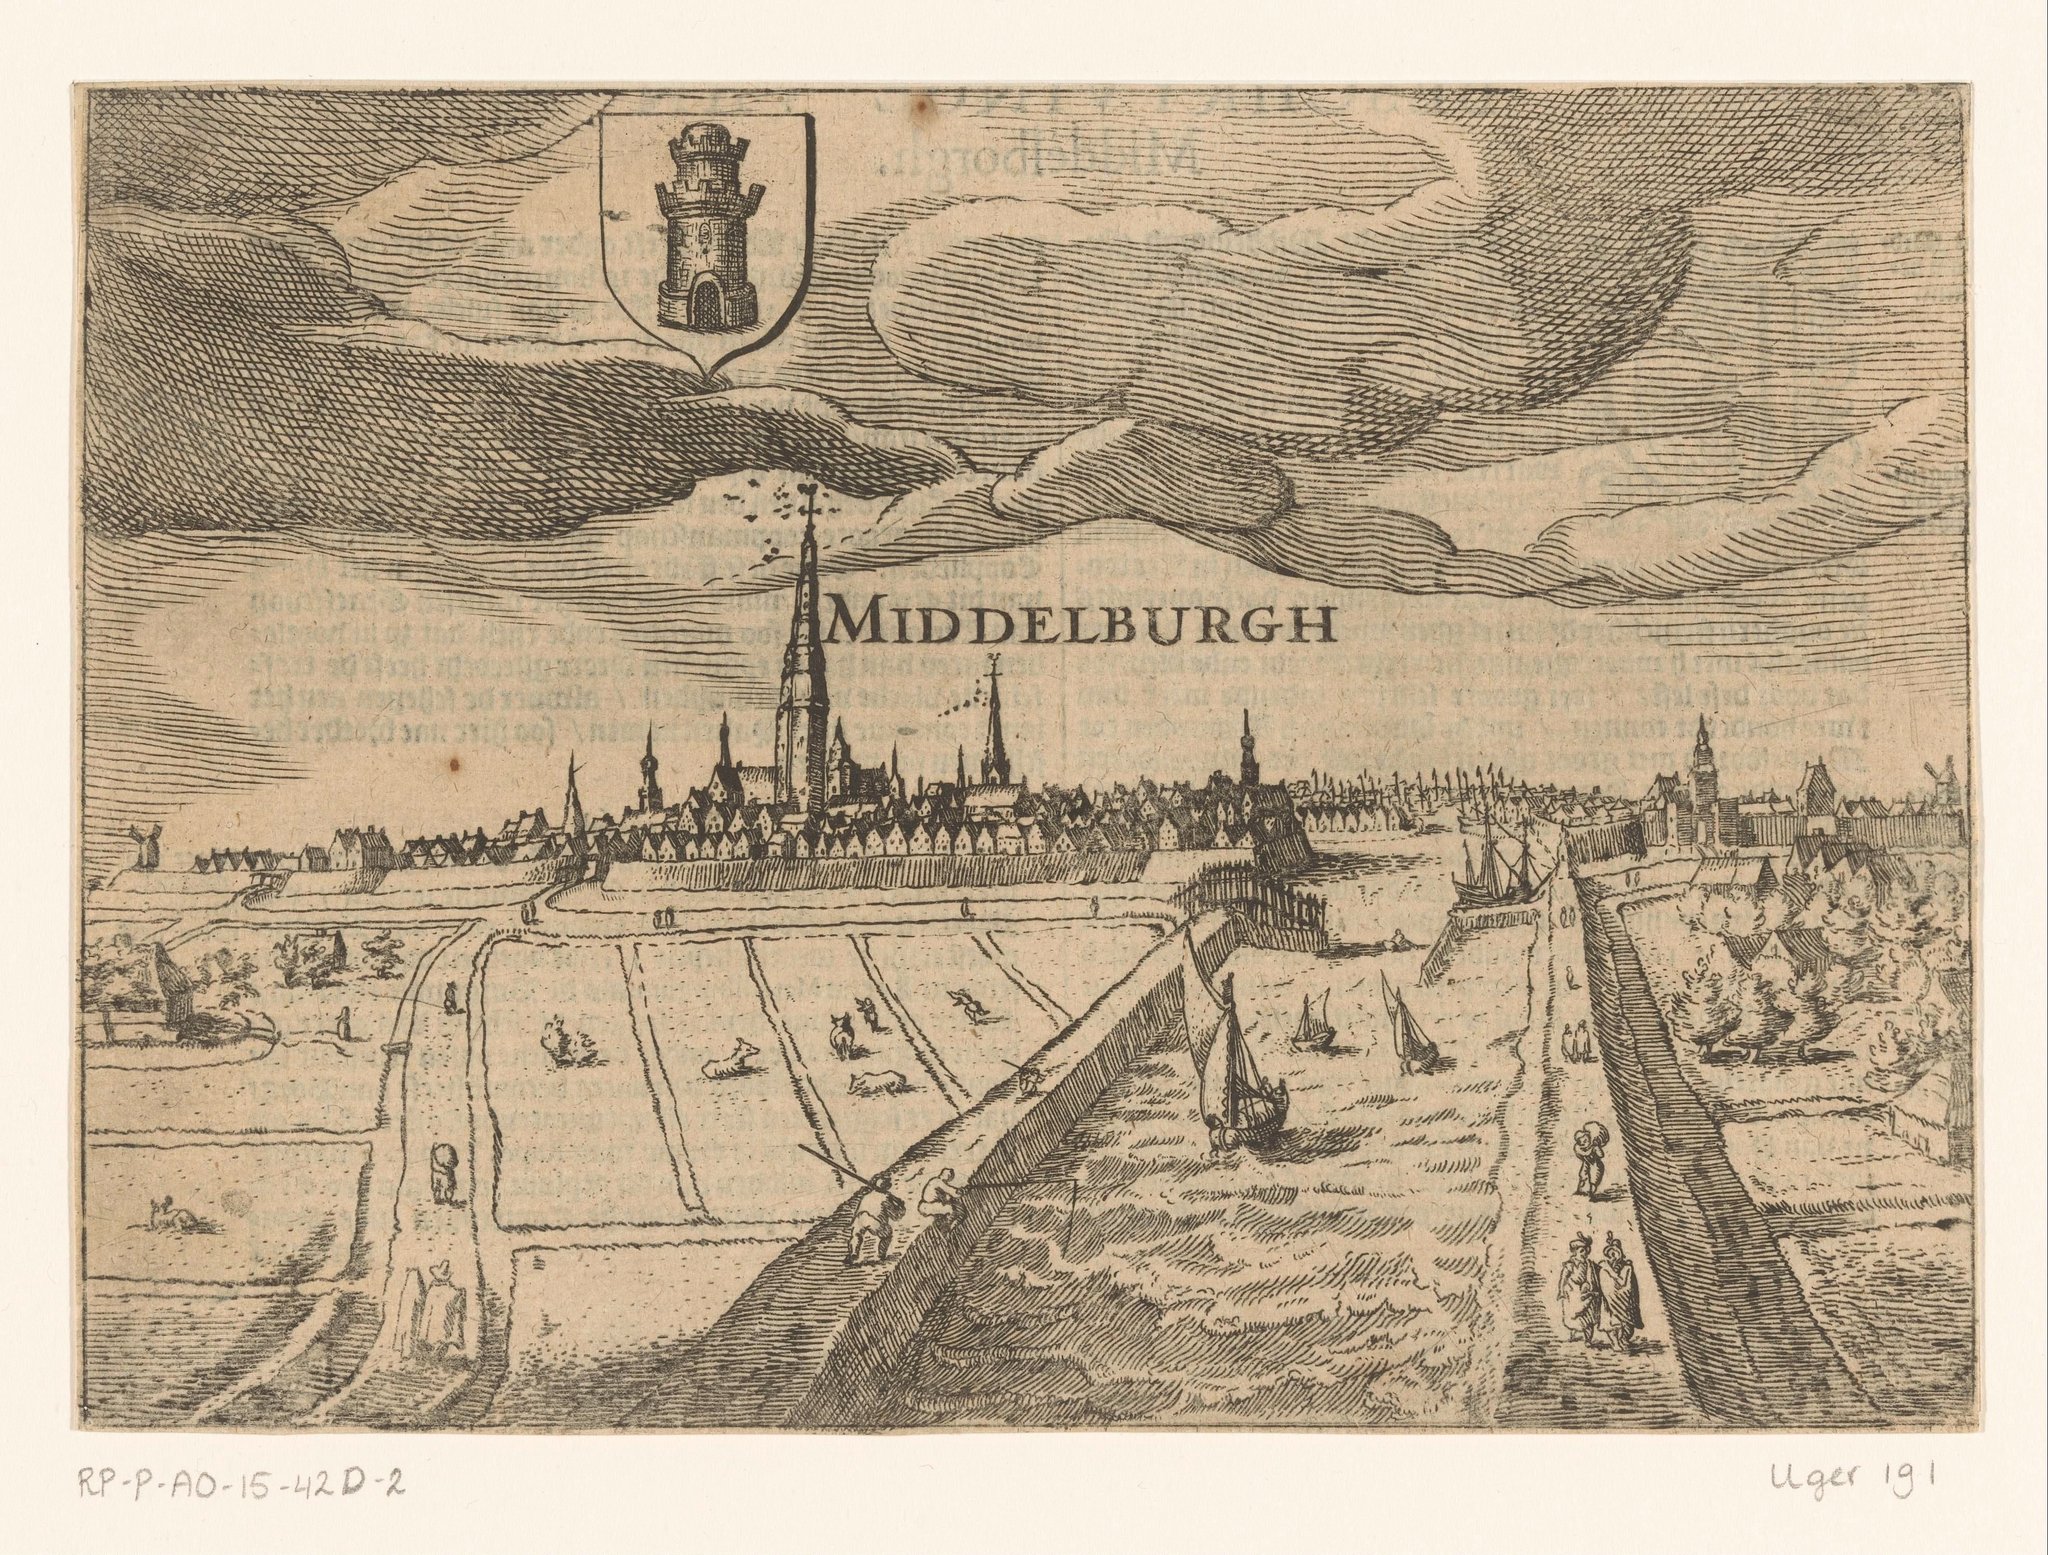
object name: print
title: Middelburgh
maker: Anonymous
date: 1617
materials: paper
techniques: engraving, etching, letterpress printing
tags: coat of arms (as symbol of the state, etc.) (+ city; municipal), church (exterior), prospect of city, town panorama, silhouette of city, middelburg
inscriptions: collector's mark: Lugt 195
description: Prent gebruikt in: Guicciardini, Lodovico. Beschrijvinghe van alle de Nederlanden, door M. Lovvijs Guicciardijn, edelman van Florencen. Met alle de caerten (…) / Description de touts les Pays-Bas, par Messire Loys Guicciardin G.H. Florentini, avec toutes les cartes geographiques (…). Arnhem: Jan Jansz, 1617. Of in: Guicciardini, Lodovico. Beschrijvinghe van alle de Neder-landen. Door Lovvijs Guicciardijn edelman van Florencen. Ende de caerten (…). Utrecht: Abraham van Herwijck, 1617.